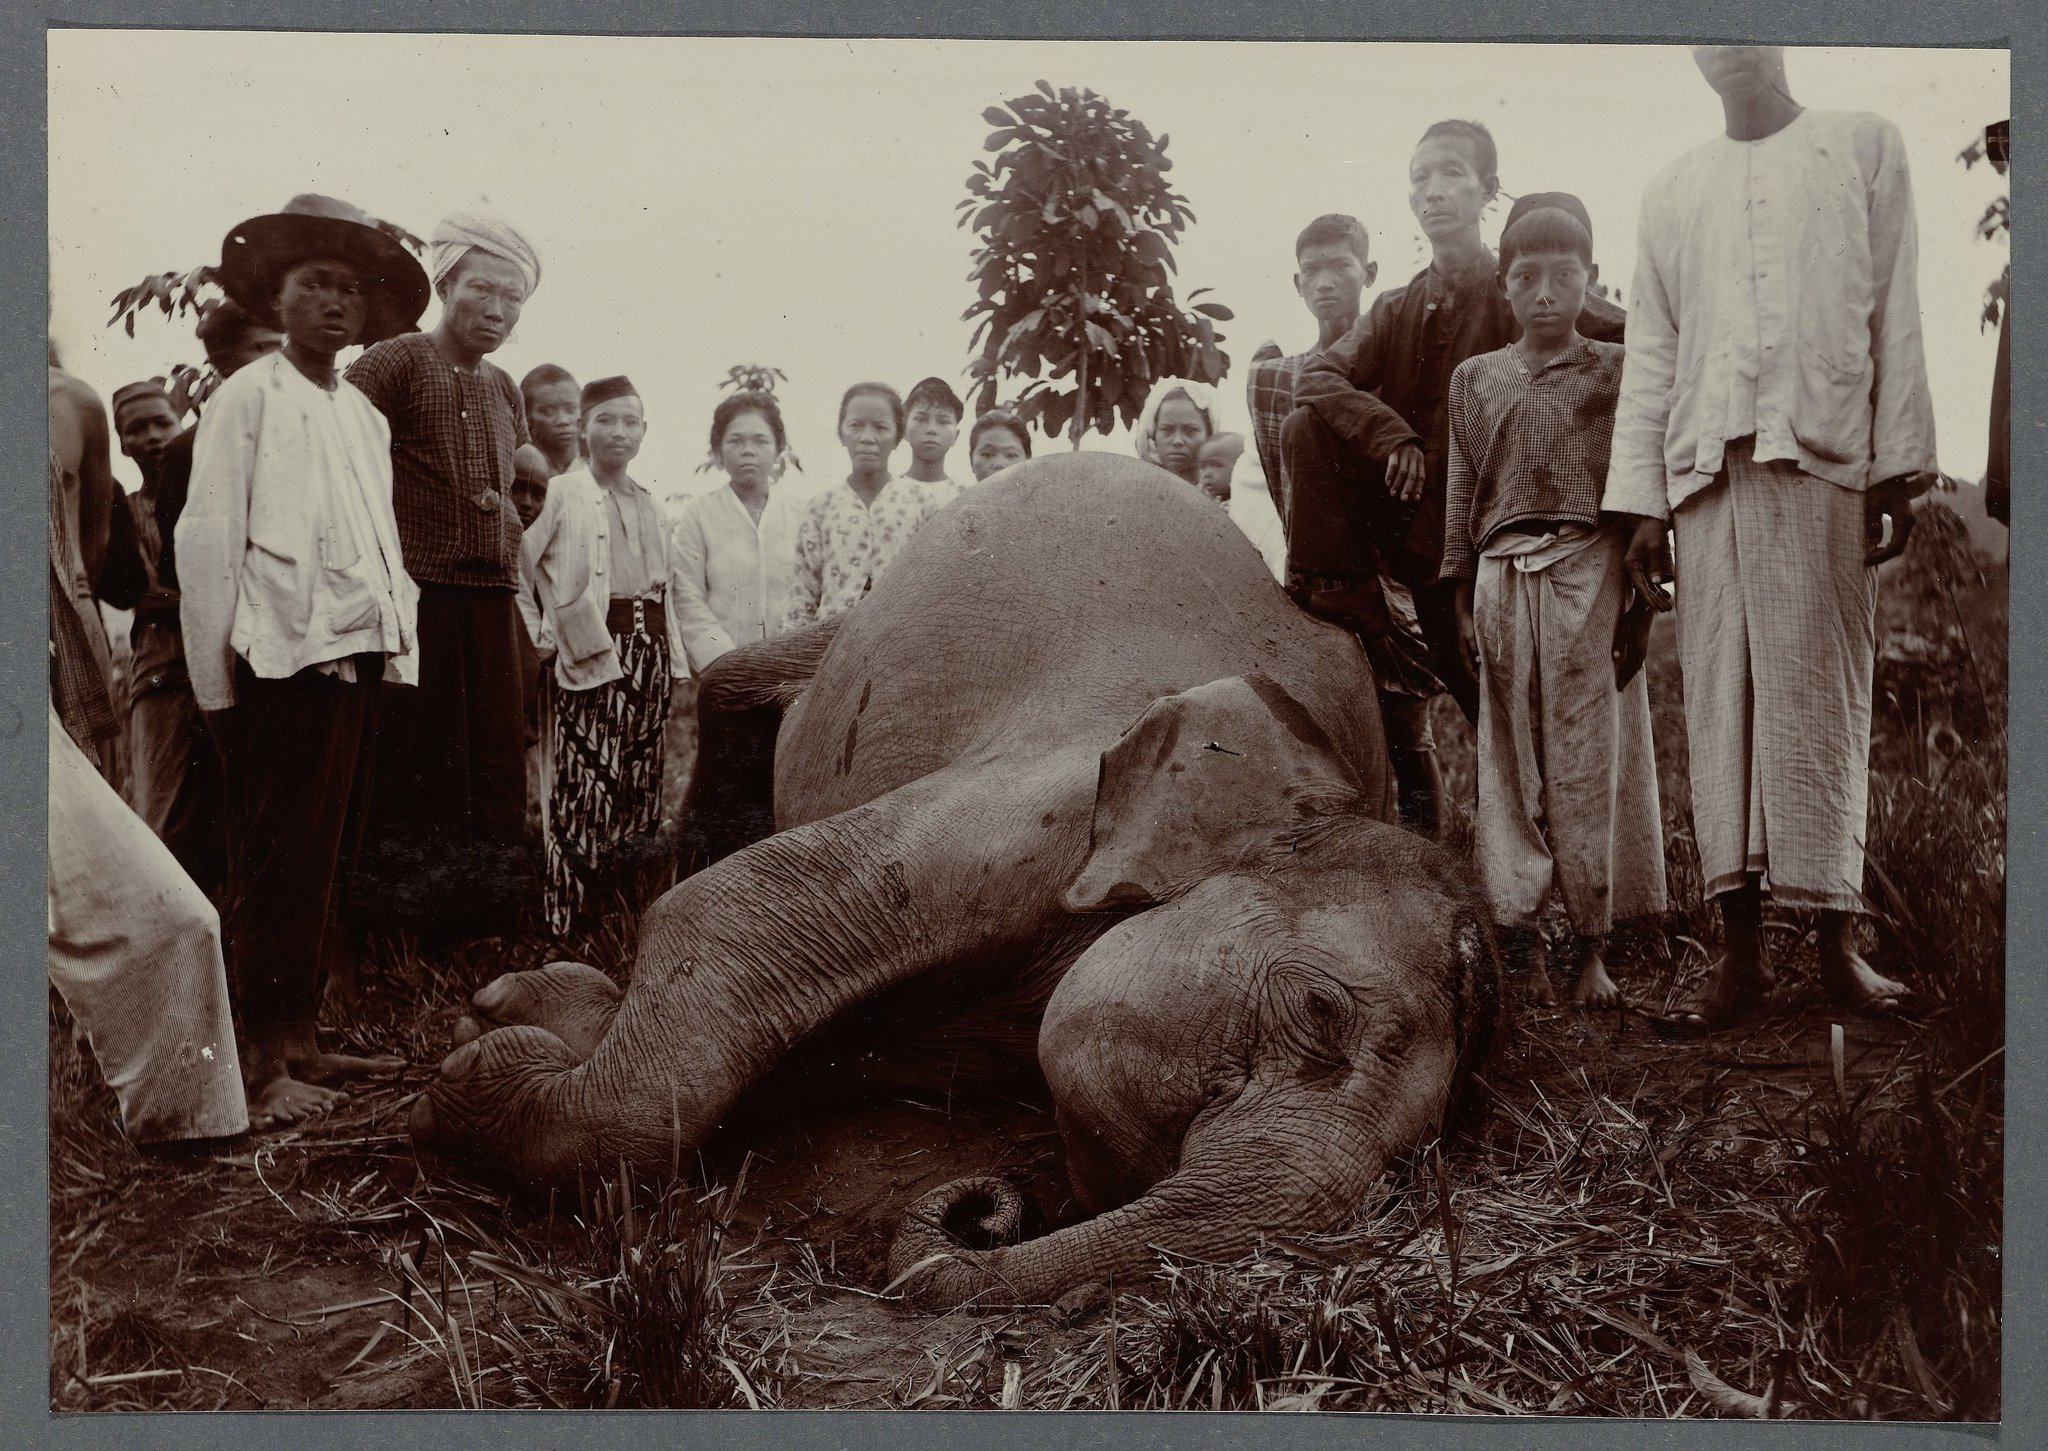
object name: photograph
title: Olifantenjacht bij Krueng Seumpo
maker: Anonymous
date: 1903-1913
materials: photographic support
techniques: gelatin silver print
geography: north sumatra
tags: arnhem, albertus dominicus laman trip, hunt ~ trunked animals, trunked animals: elephant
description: Na de expedities naar de Gajo- en Alaslanden o.l.v. Van Daalen (eerste tocht in 1901), werd hij in 1903 belast met voorbereiding van permanente vestiging van Nederlands gezag. Aanleg van een weg van de Noordkust naar het binnenland was hierbij van groot belang. Deze zgn. Gajoweg werd aangelegd tussen 1903 en 1914, van Bireuen aan de kust naar Takinguen aan het bergmeer Danau Lauttawar, totale lengte 104 km.